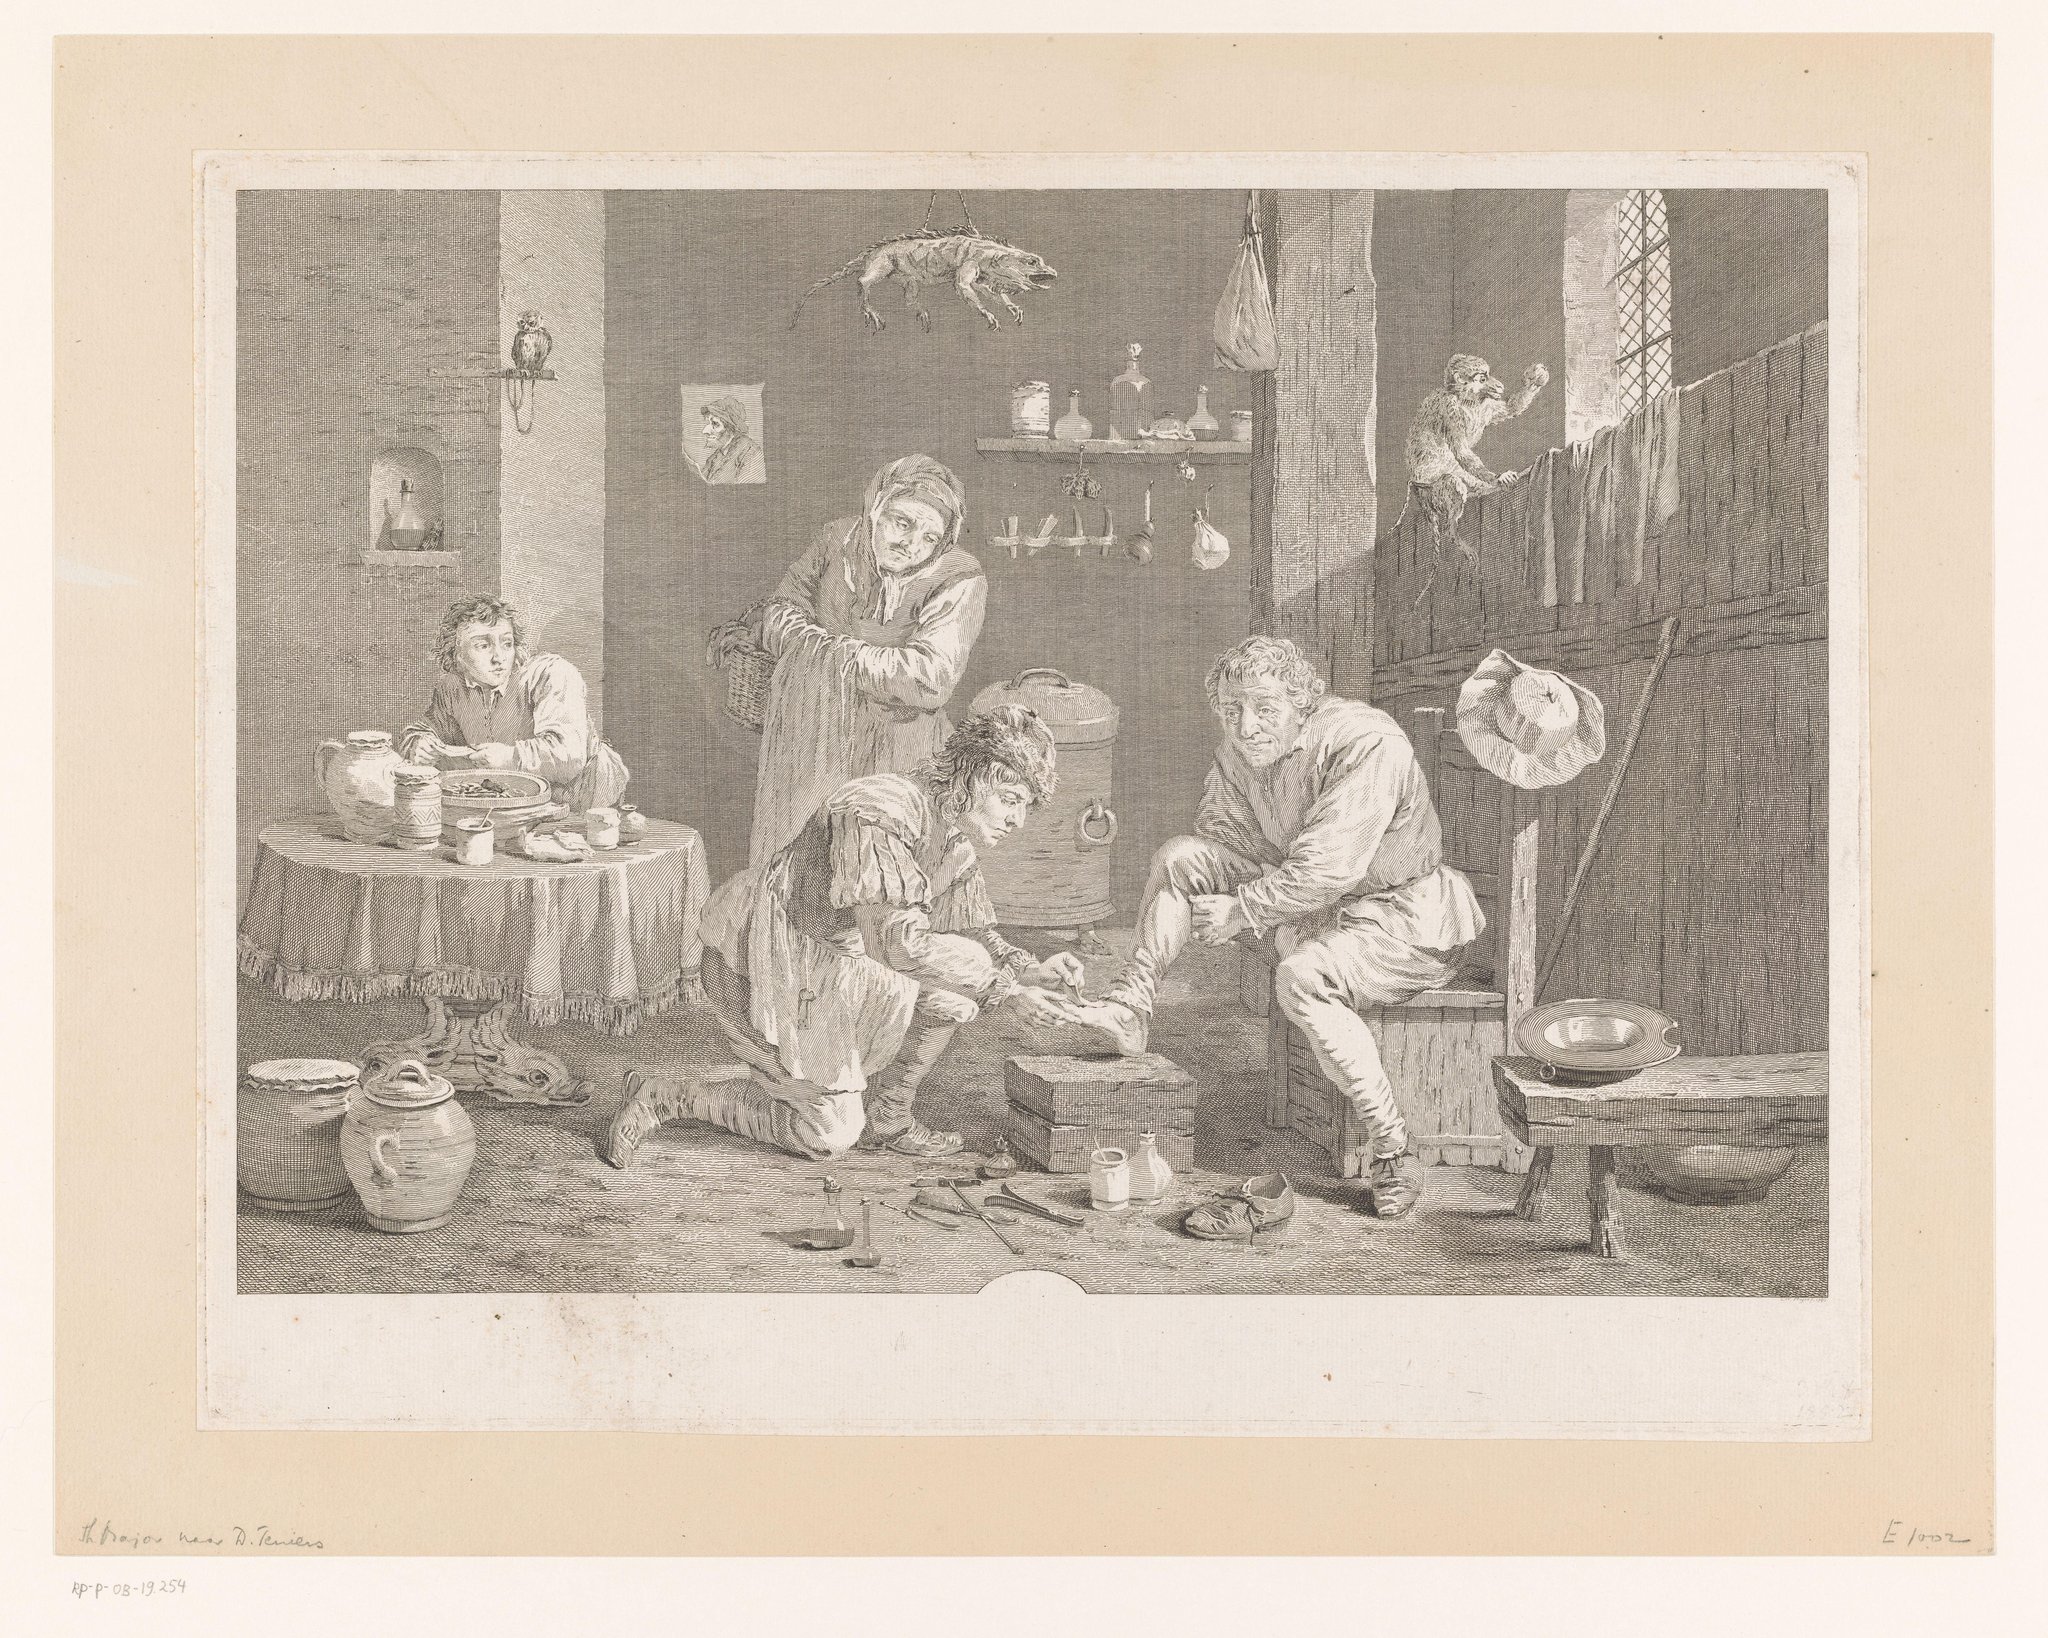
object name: print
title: Le Chirurgien de Campagne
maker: thomas major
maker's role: print maker, publisher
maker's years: 1714-1799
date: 1724-1747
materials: paper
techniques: engraving, etching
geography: paris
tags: pharmacist, druggist, apothecary; pharmacy, drugstore, dispensing chemist, barber; surgeon, other 'operations'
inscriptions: collector's mark: Lugt 240